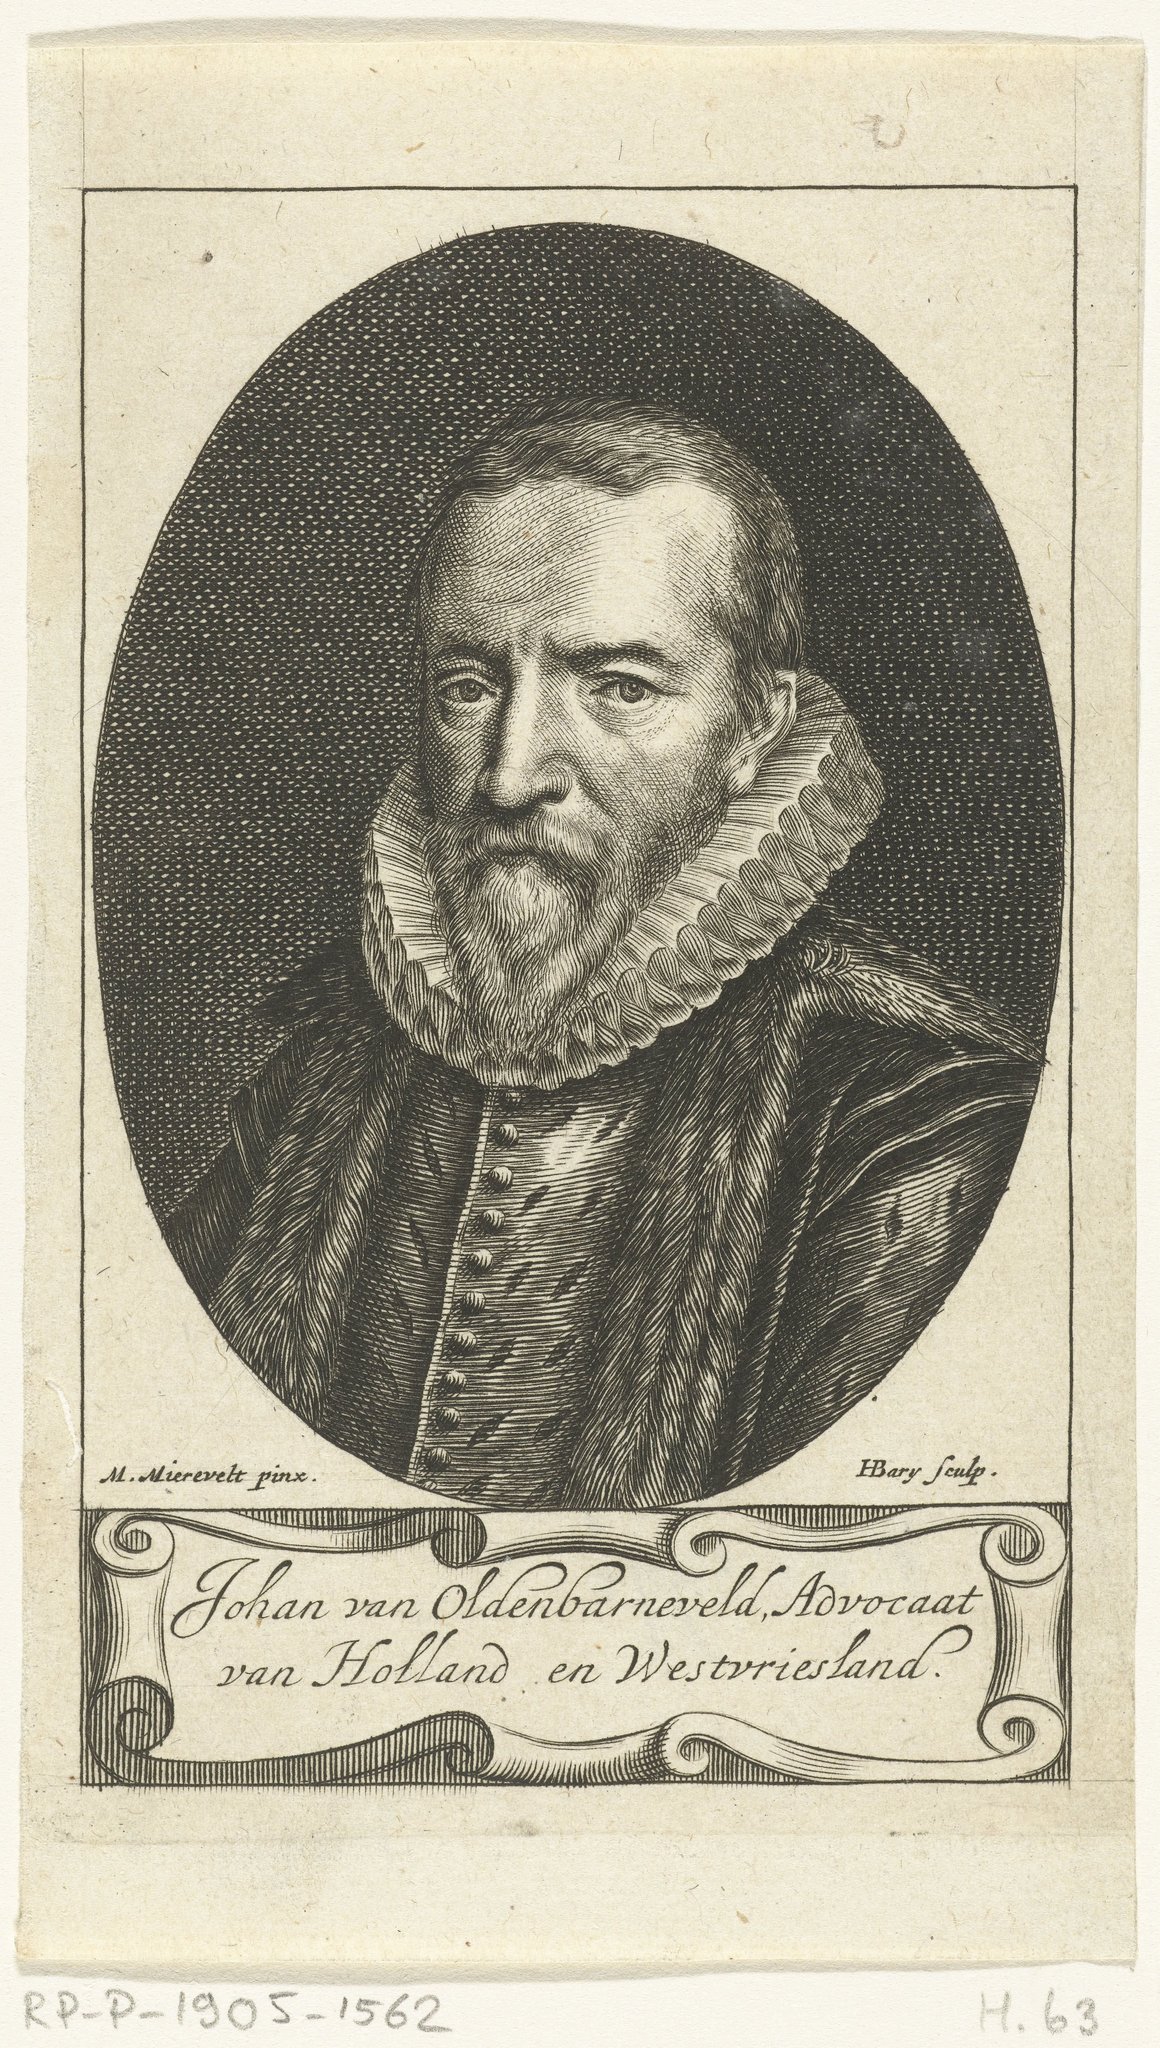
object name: print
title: Portret van Johan van Oldenbarnevelt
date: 1657-1707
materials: paper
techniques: engraving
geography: netherlands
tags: johan van oldenbarnevelt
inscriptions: collector's mark: Lugt 2228